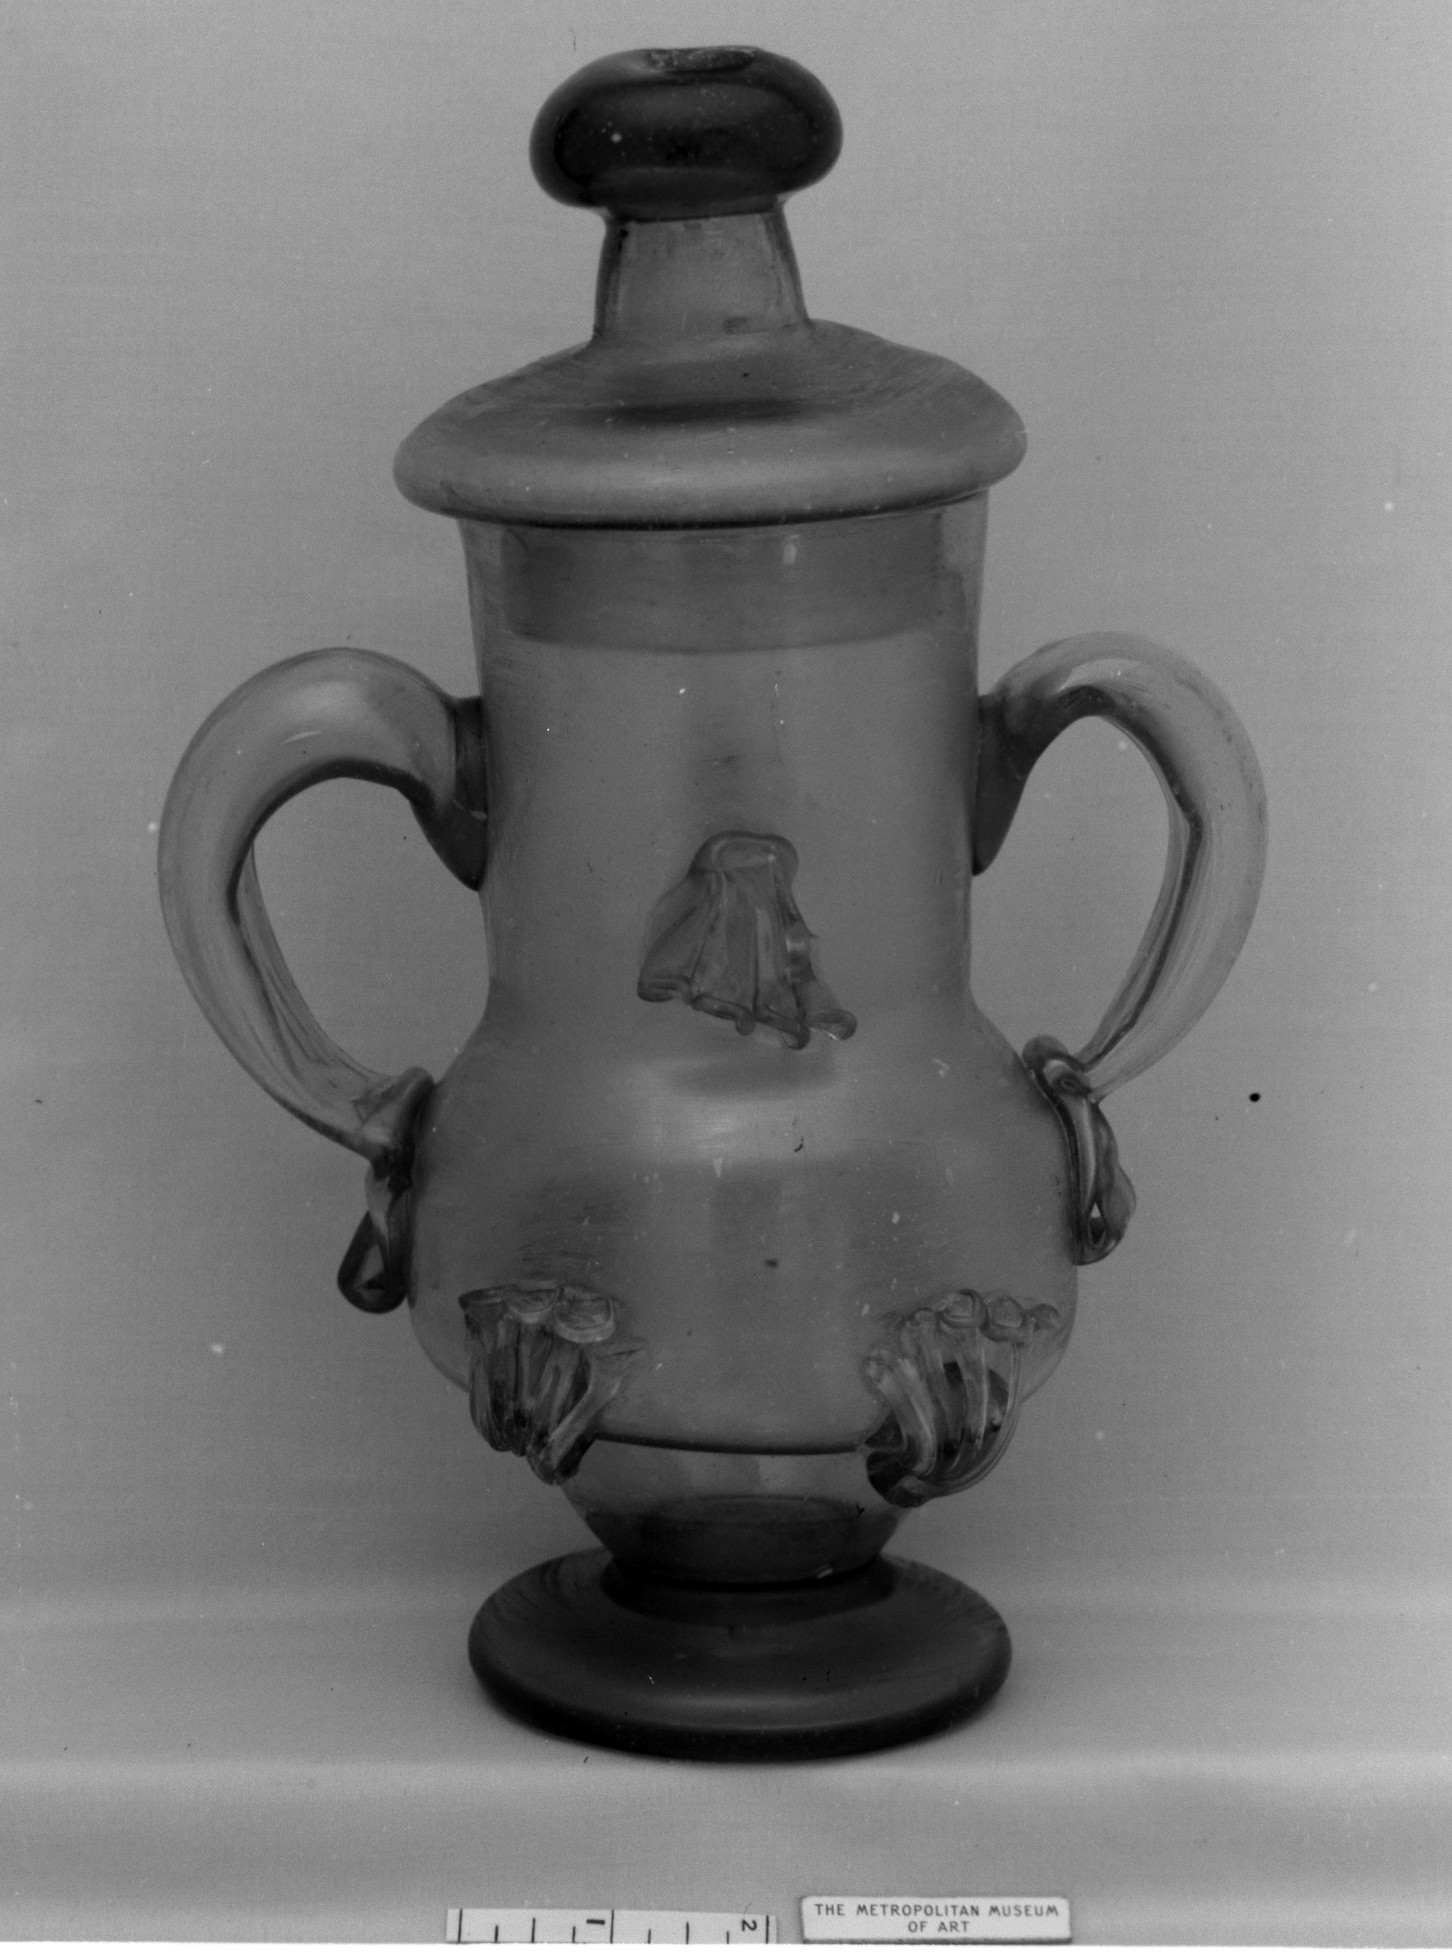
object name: vase with cover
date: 1701-1800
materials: glass